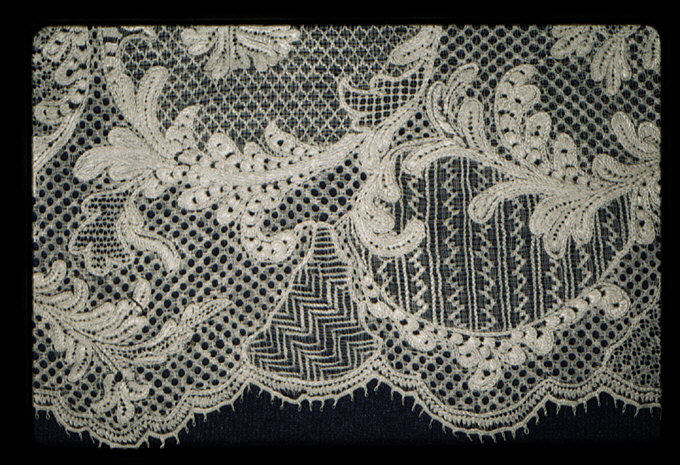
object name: border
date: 1701-1800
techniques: embroidery